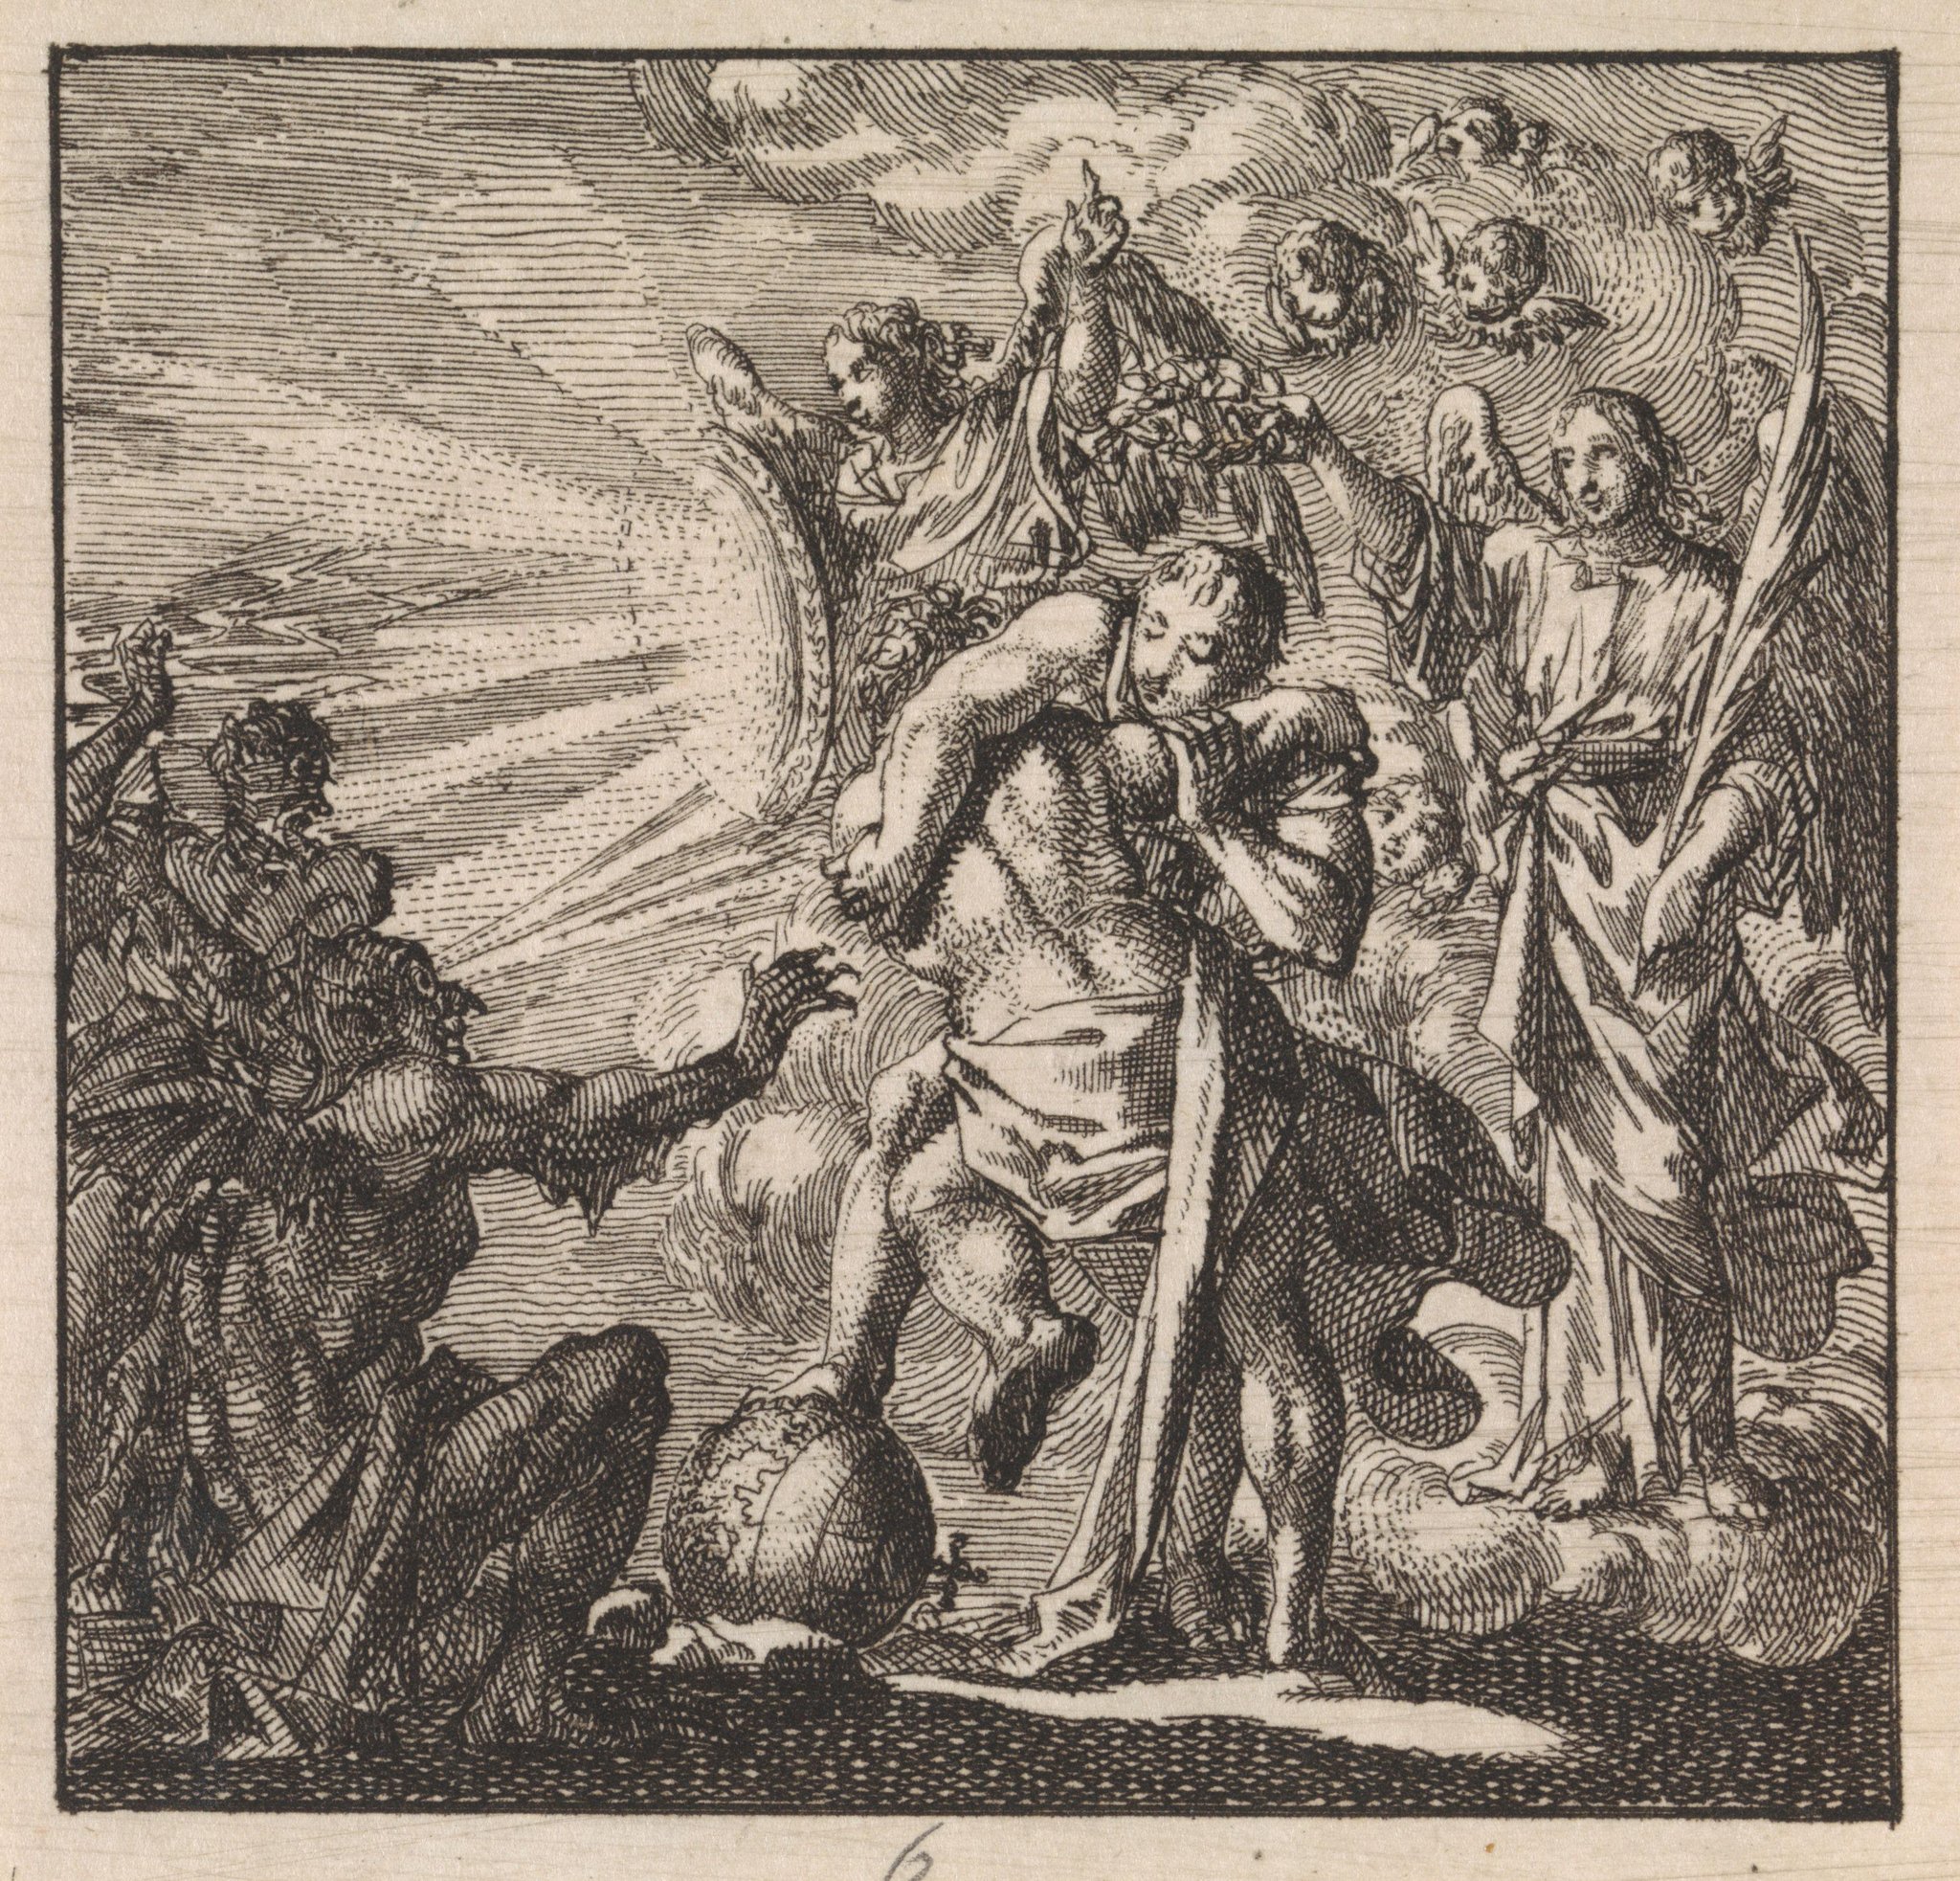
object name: print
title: Worstelpartij tussen personificaties van Gelatenheid en Eigenwil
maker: jan luyken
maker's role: draughtsman, print maker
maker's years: 1649-1712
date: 1710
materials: paper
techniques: etching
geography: amsterdam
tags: wrestling (sport) (+ variant), devil(s) and demons, globe, angels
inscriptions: collector's mark: Lugt 2228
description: Proefdruk voor illustratie uit: Luyken, Jan. De onwaardige wereld, vertoond in vyftig zinnebeelden, met godlyke spreuken en stichtelyke verzen. Amsterdam: Pieter Arentsz. II (wed.) en Cornelis van der Sys, 1710, p. 22.